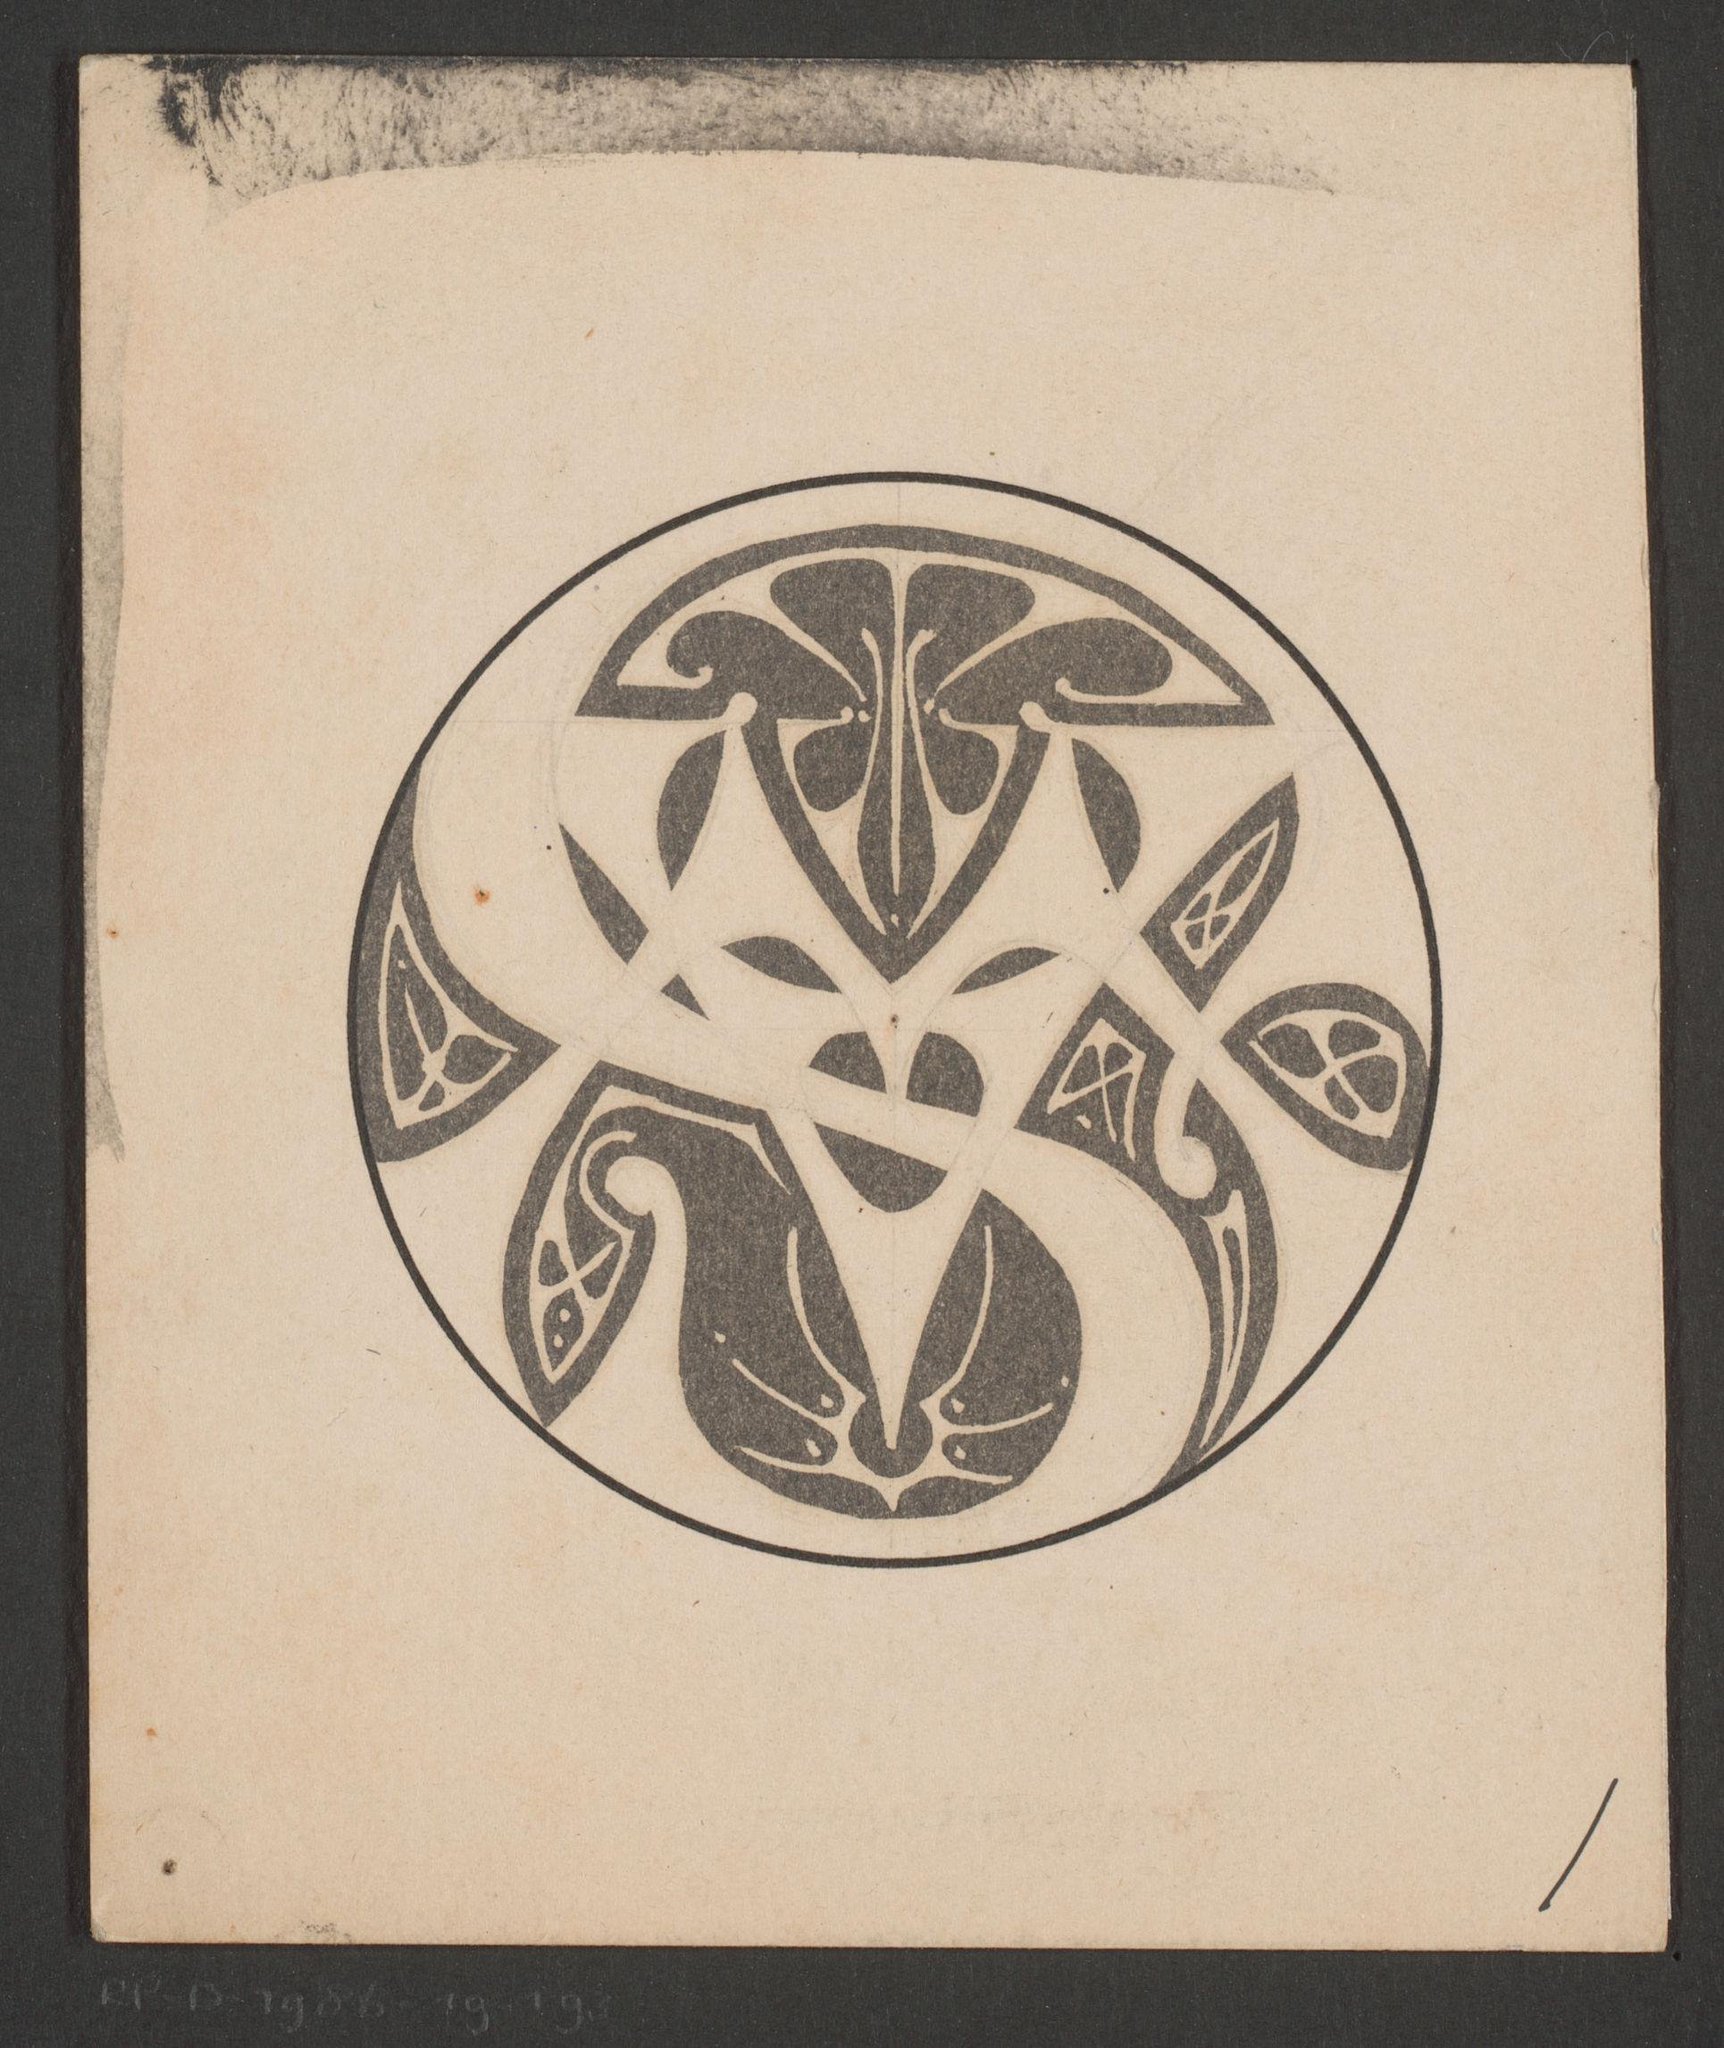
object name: print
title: Vignet met monogram AWS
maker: reinier willem petrus de vries (1874-1953)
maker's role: draughtsman, print maker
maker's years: 1874-1953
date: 1901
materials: paper, pencil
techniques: relief print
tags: leiden, publisher, albertus willem sijthoff, magic mathematical figures; magic numbers, words, monograms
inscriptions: inscription: ‘No 3003/ WIT ROYAL 50 bij 65 ctm 60 KILO.’, collector's mark: ‘R:MVS.’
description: De boekbindersstempel waarvoor dit ontwerp is bedoeld zou gebruikt worden voor de band van een album voor A.W. Sijthoff ter gelegenheid van diens vijftigjarige uitgeversloopbaan.